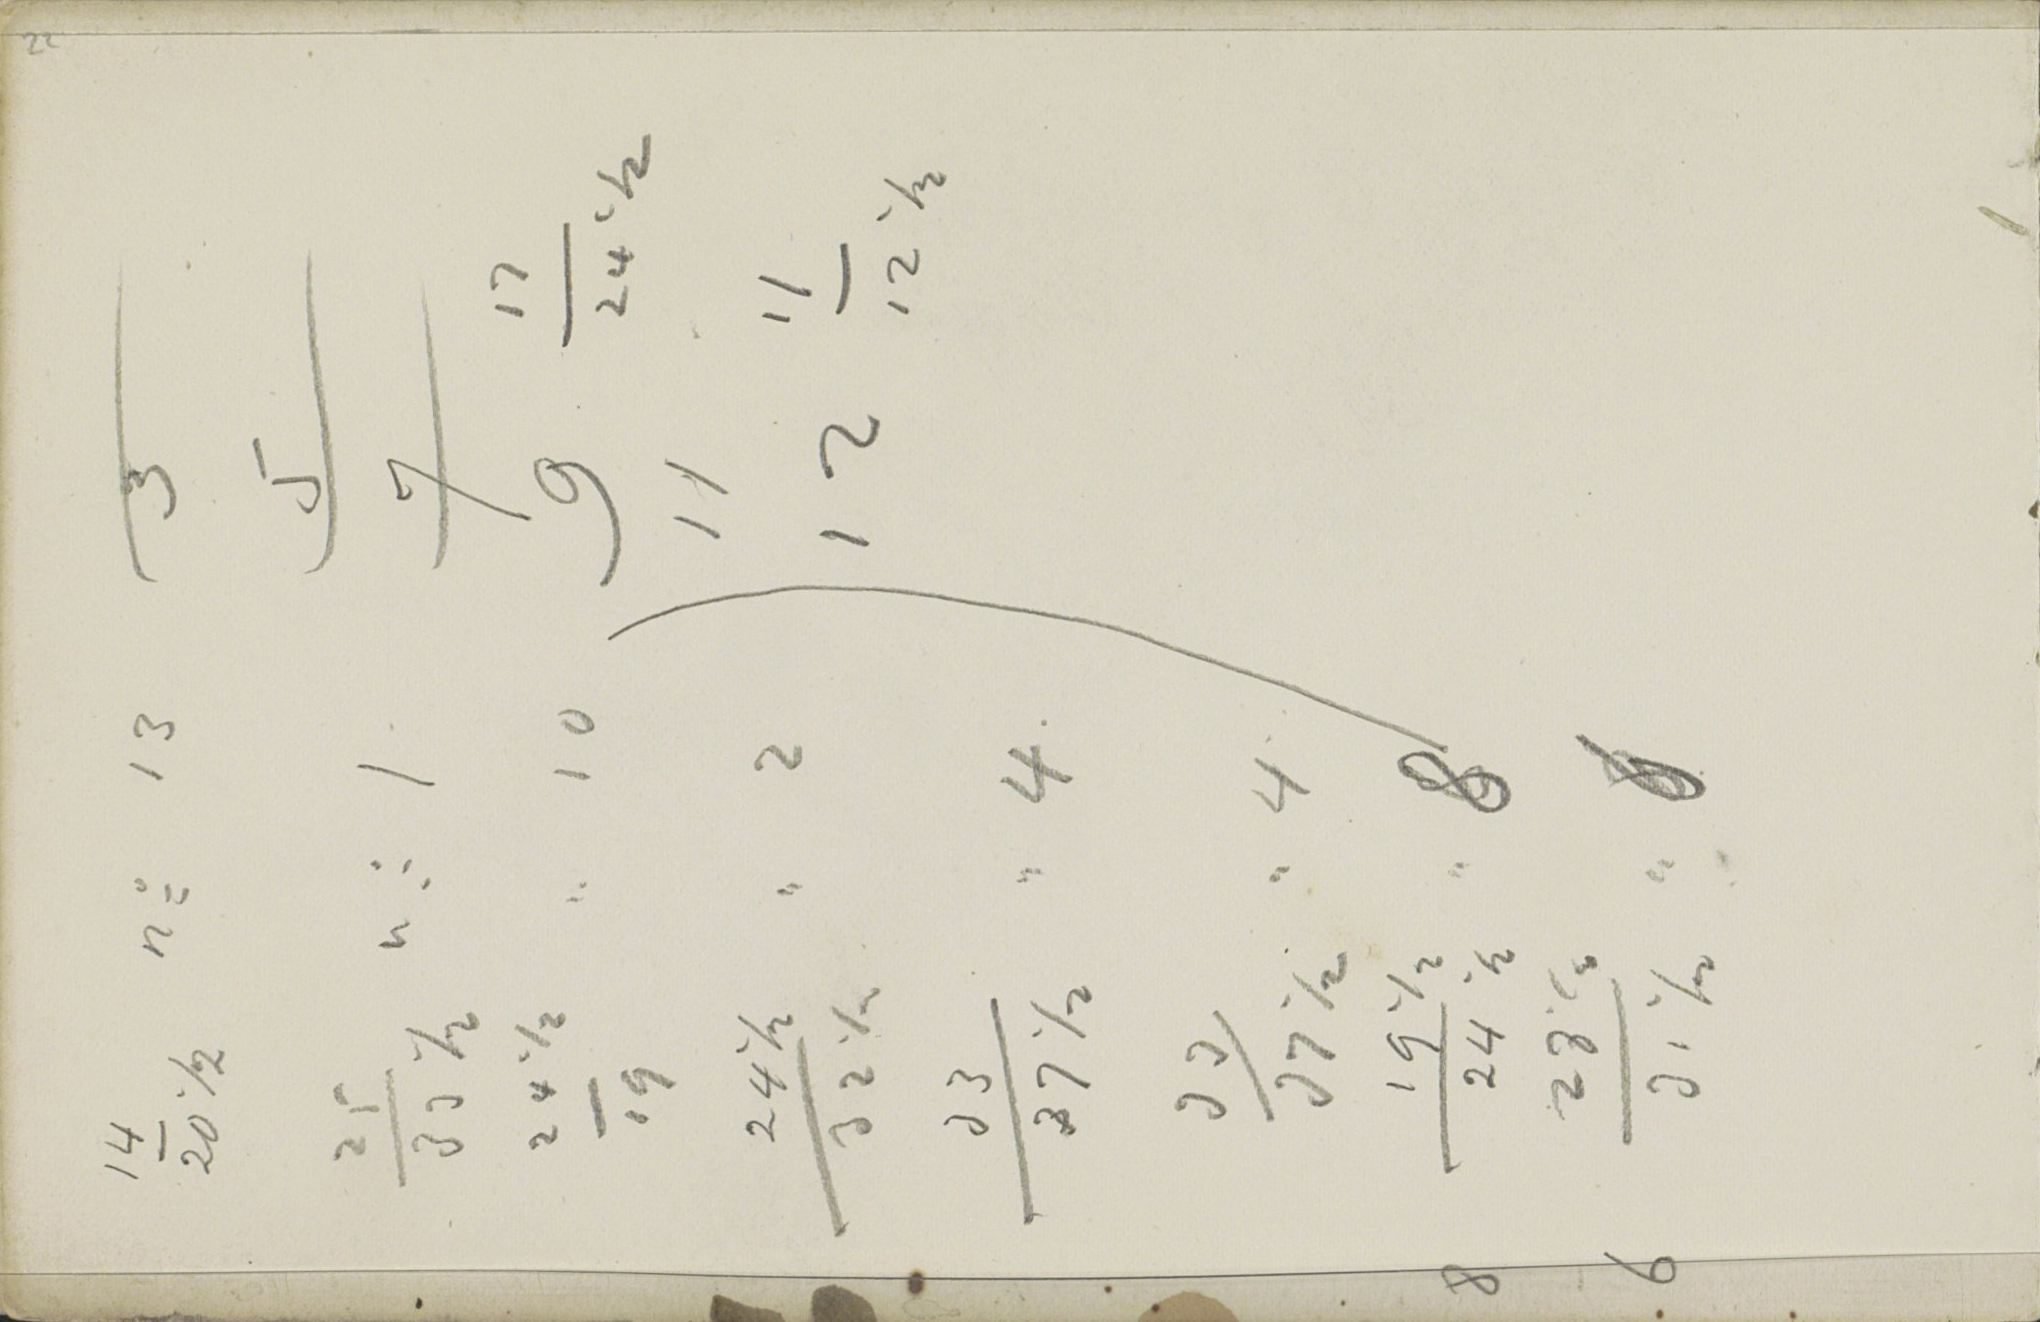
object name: sketchbook leaf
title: Annotaties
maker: willem witsen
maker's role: draughtsman, painter, print maker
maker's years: 1860-1923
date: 1888-1891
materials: paper, pencil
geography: london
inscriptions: annotation: ‘[...]’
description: Pagina 22 uit een schetsboek met 19 bladen.